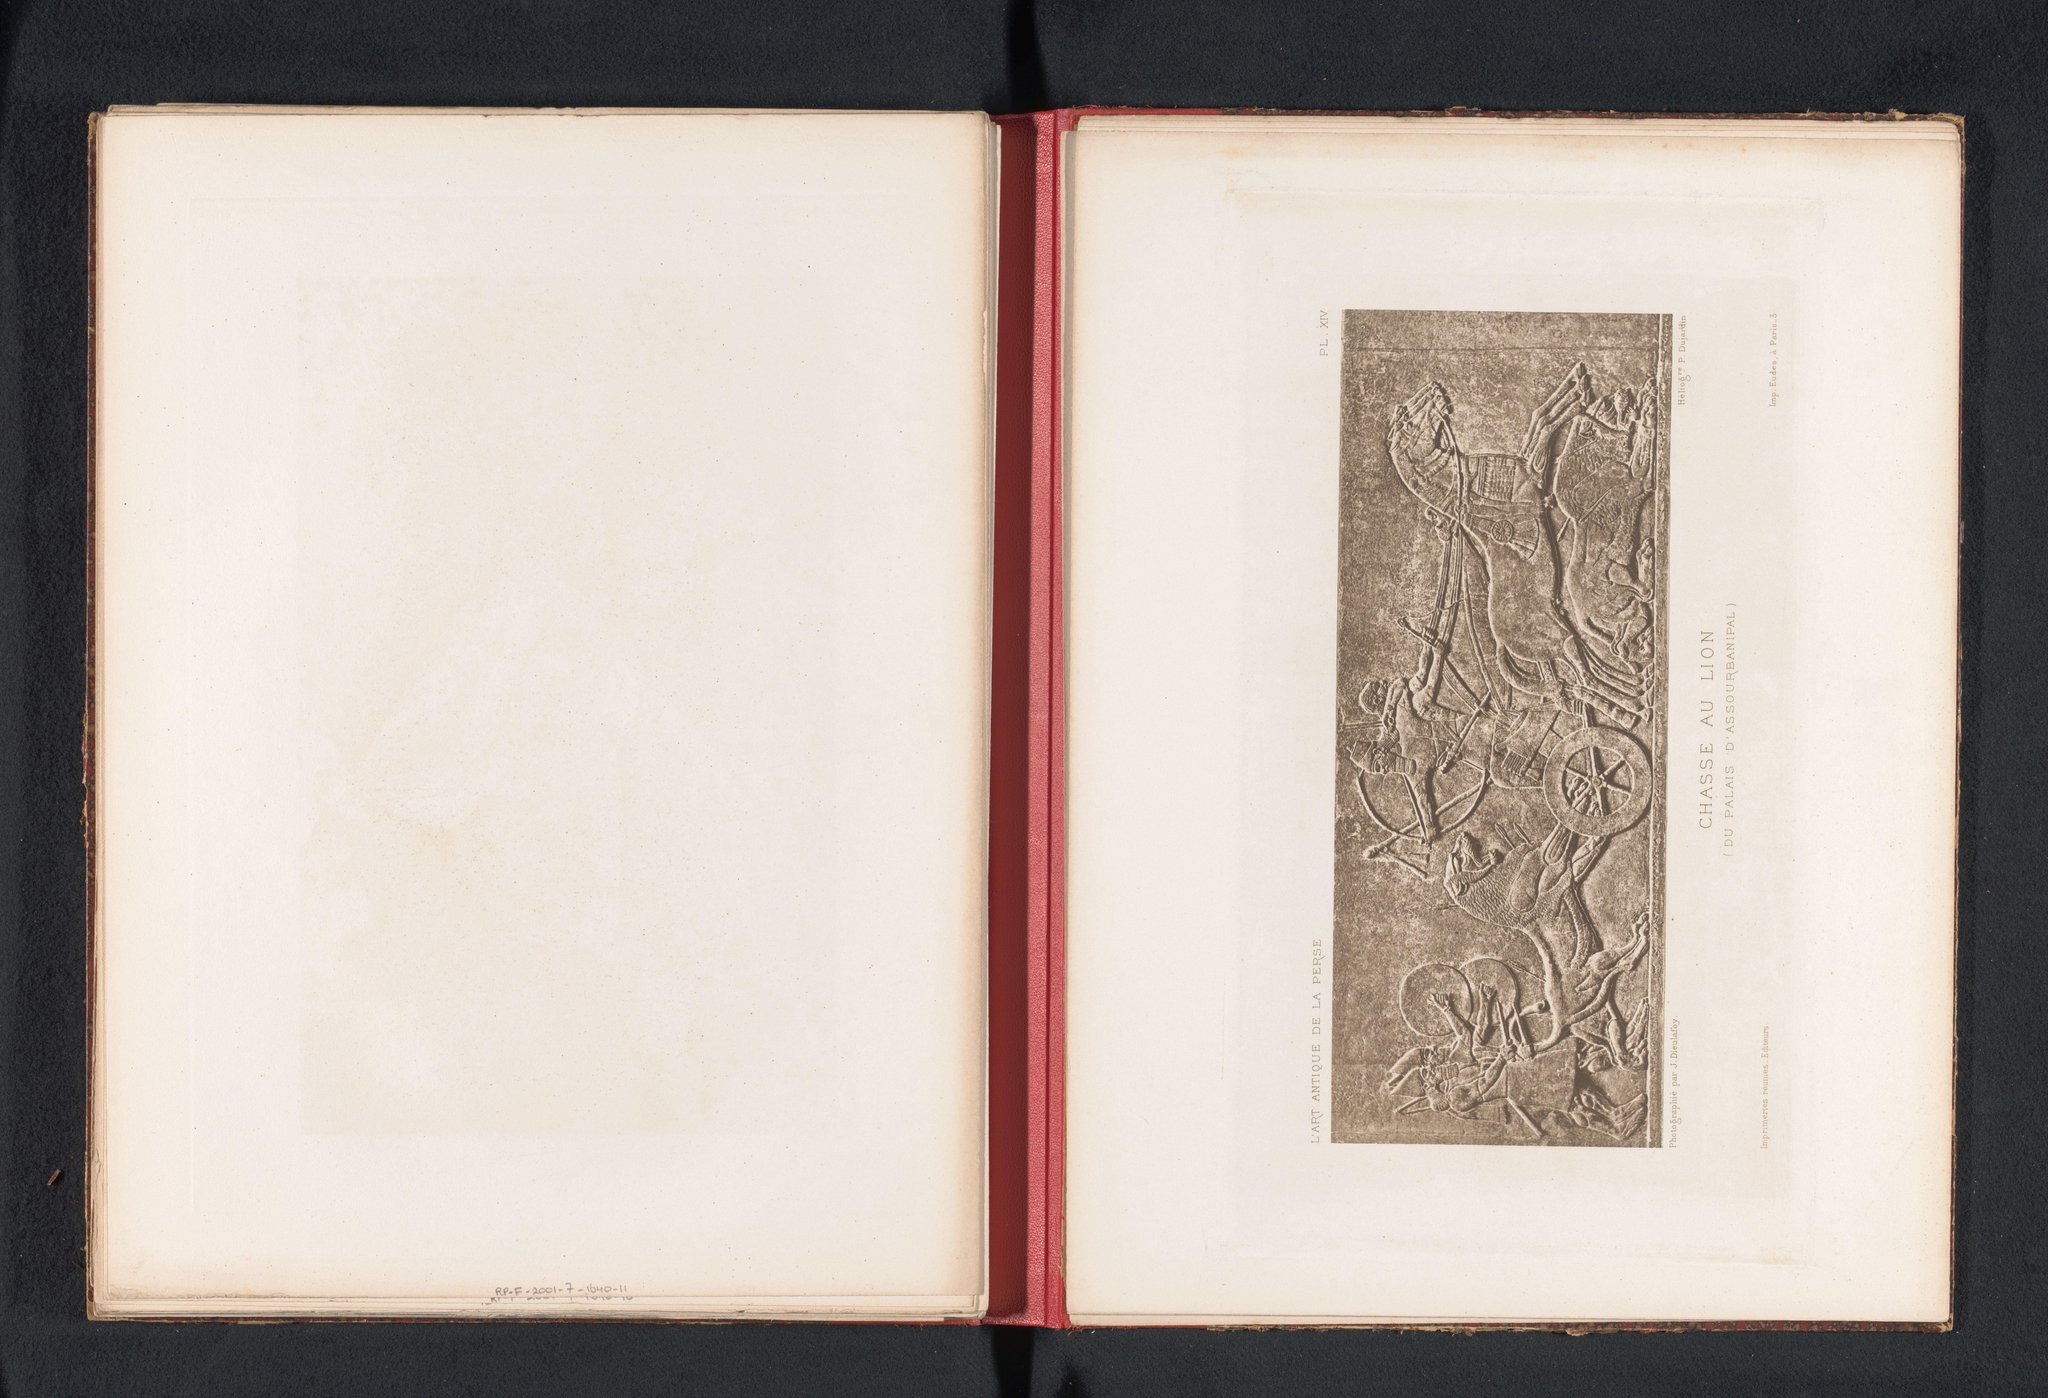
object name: photomechanical print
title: Chasse au Lion (du Palais d'Assourbanipal)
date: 1880-1885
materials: paper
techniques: photoaquatint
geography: babylon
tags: lion hunt, sculpture (+ relief ~ sculpture)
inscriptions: inscription: ‘Imprimeries réunies_Editeurs. Imp. Eudes, à Paris_3.’, number: ‘PL. XIV’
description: Deze prent maakt deel uit van een omslag met twintig prenten op zeventien bladen en vijftien tekstbladen.